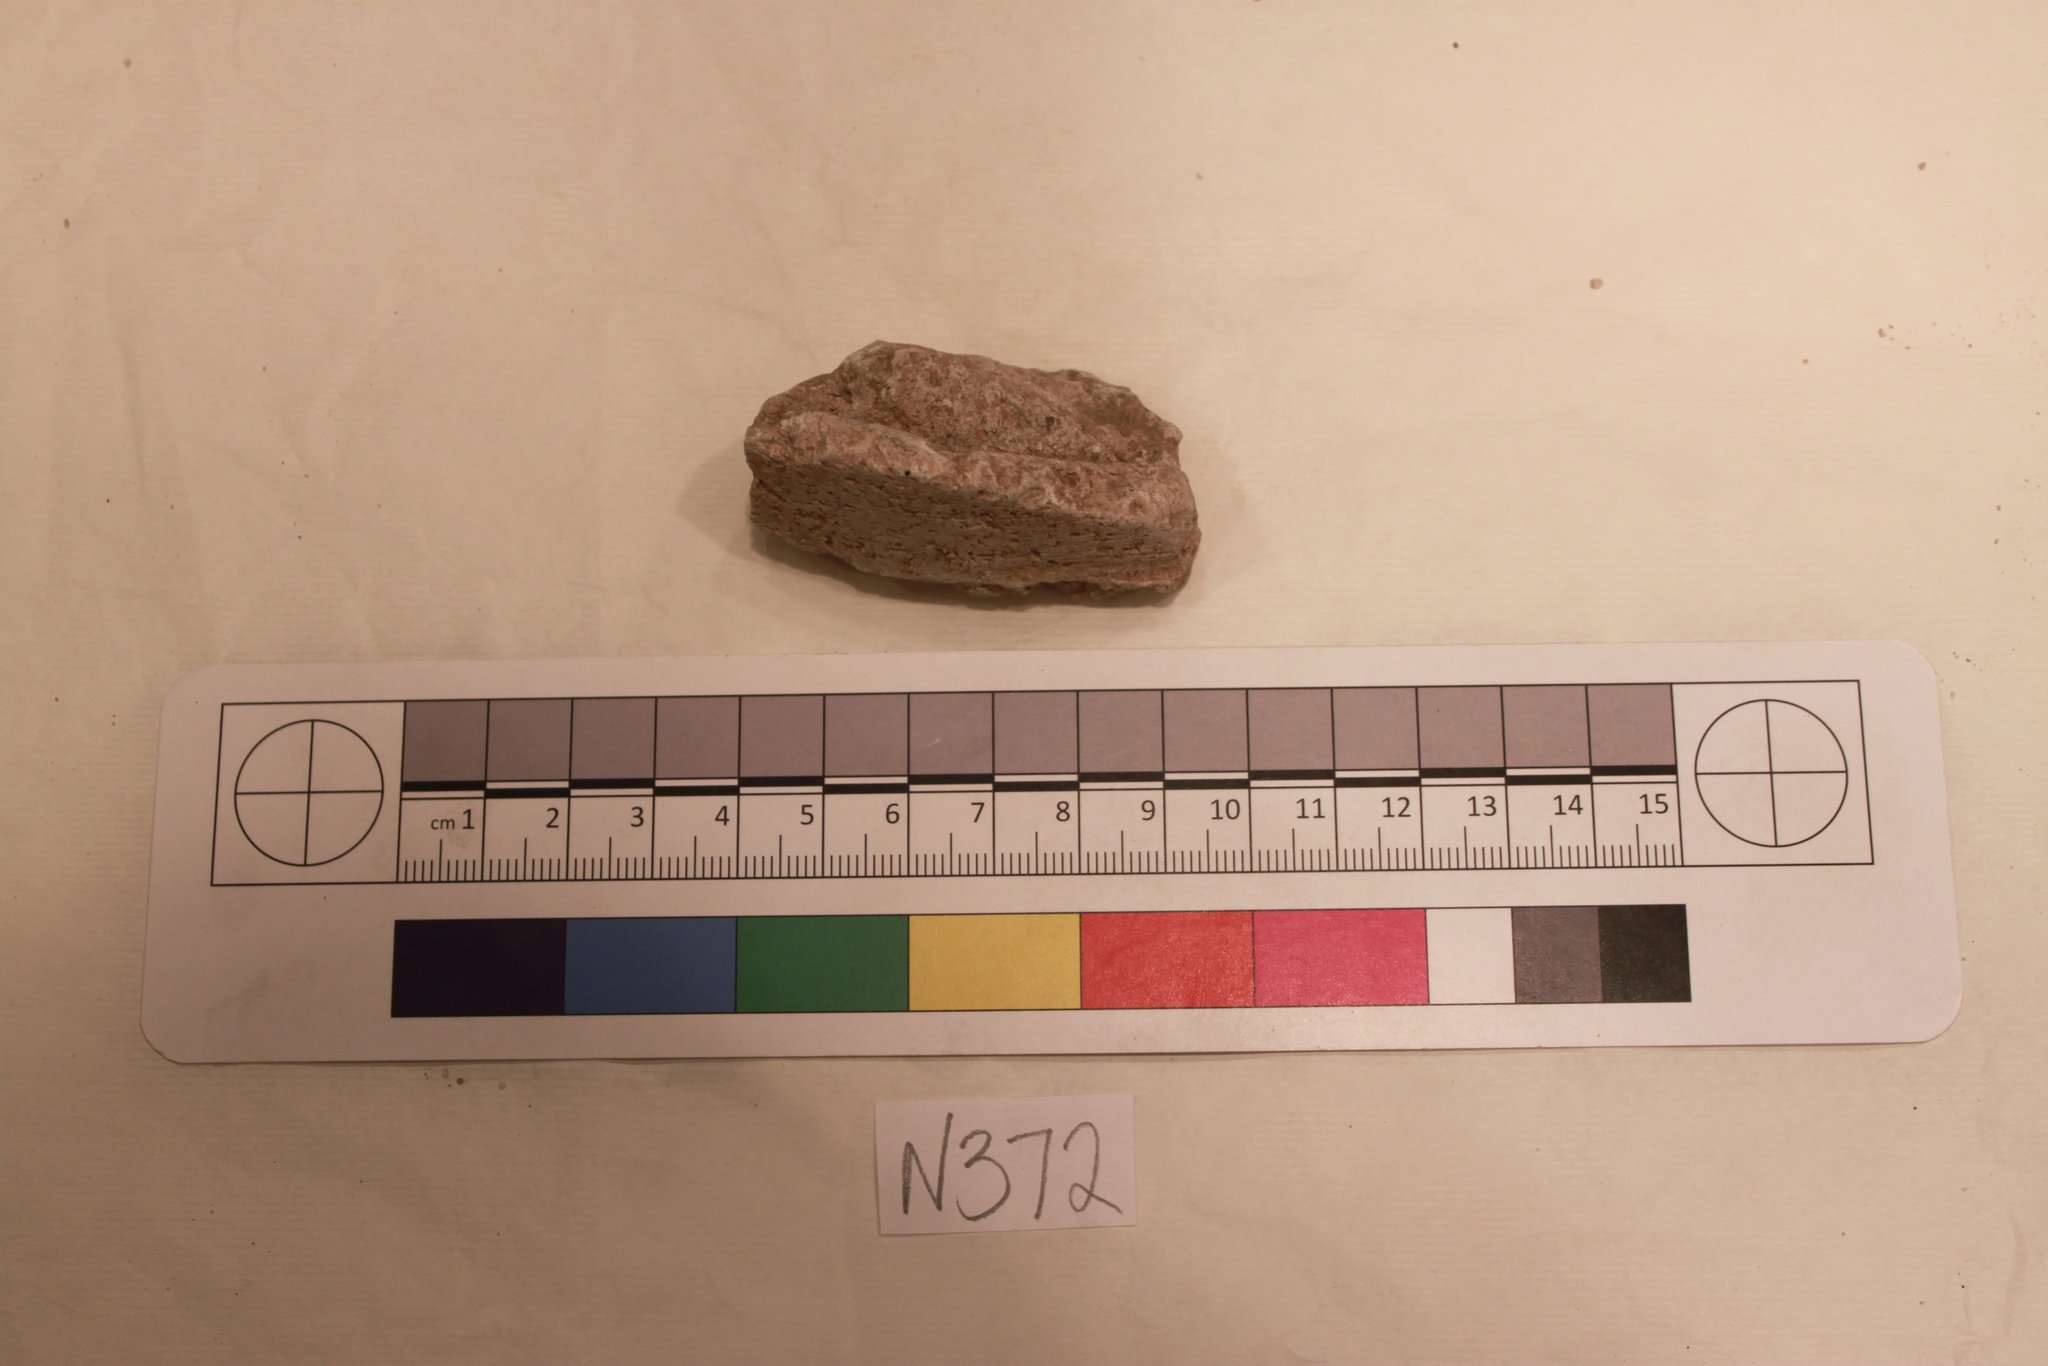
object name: fragment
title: Stucco Fragment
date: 701-1200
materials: plaster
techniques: carving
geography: iran